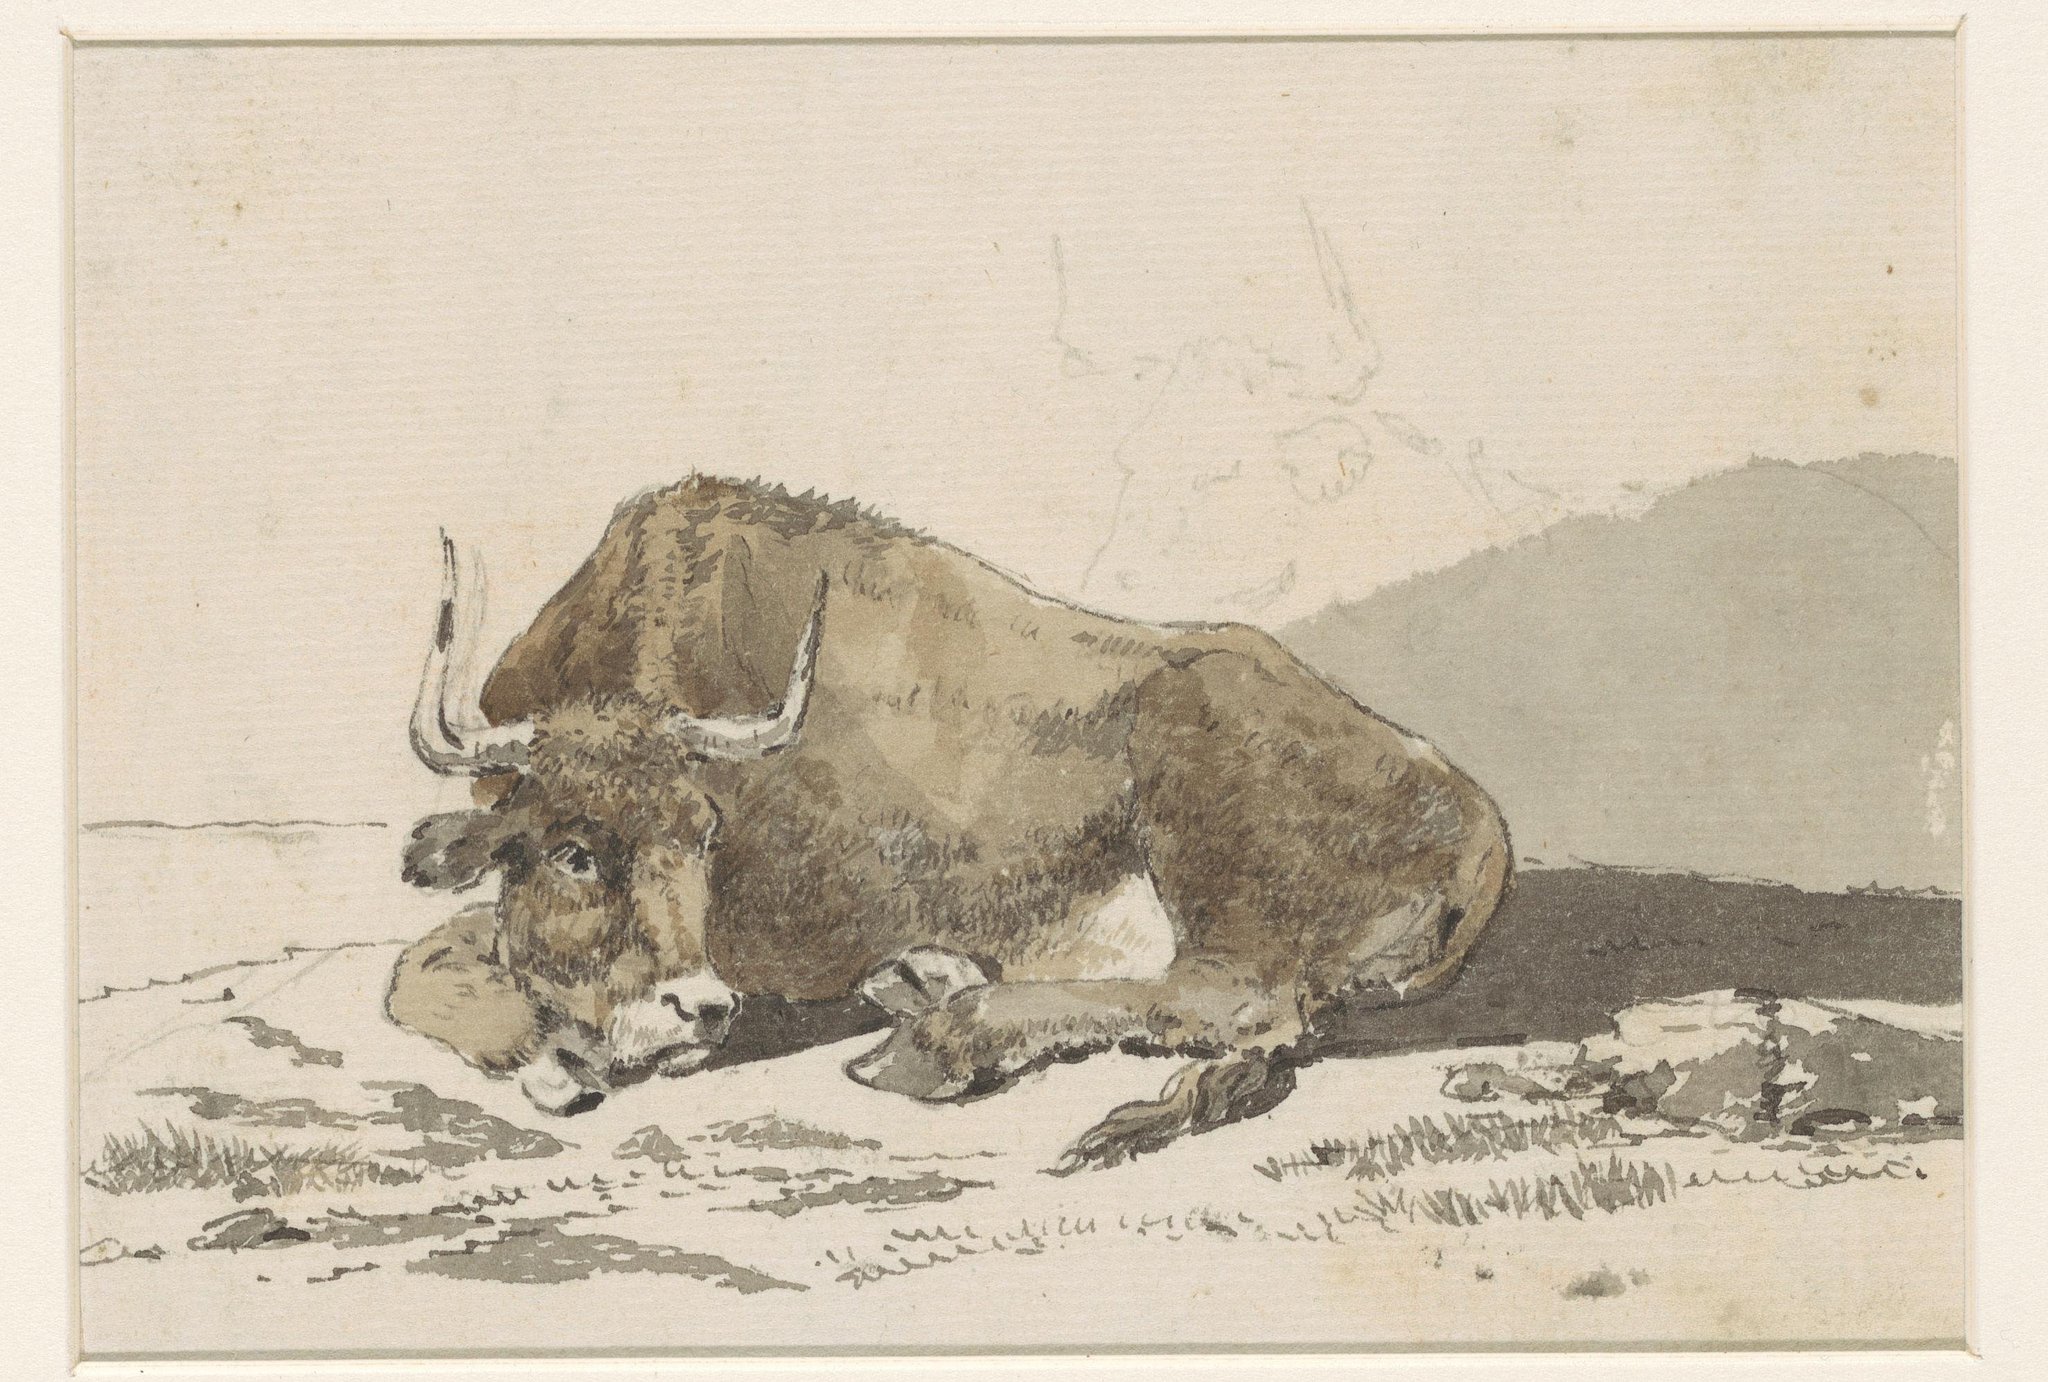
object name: drawing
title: Liggend rund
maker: david alphonse de sandoz-rollin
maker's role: draughtsman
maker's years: 1740-1809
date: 1750-1809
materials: ink, paper, pencil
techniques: brush, pen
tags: bovine cattle